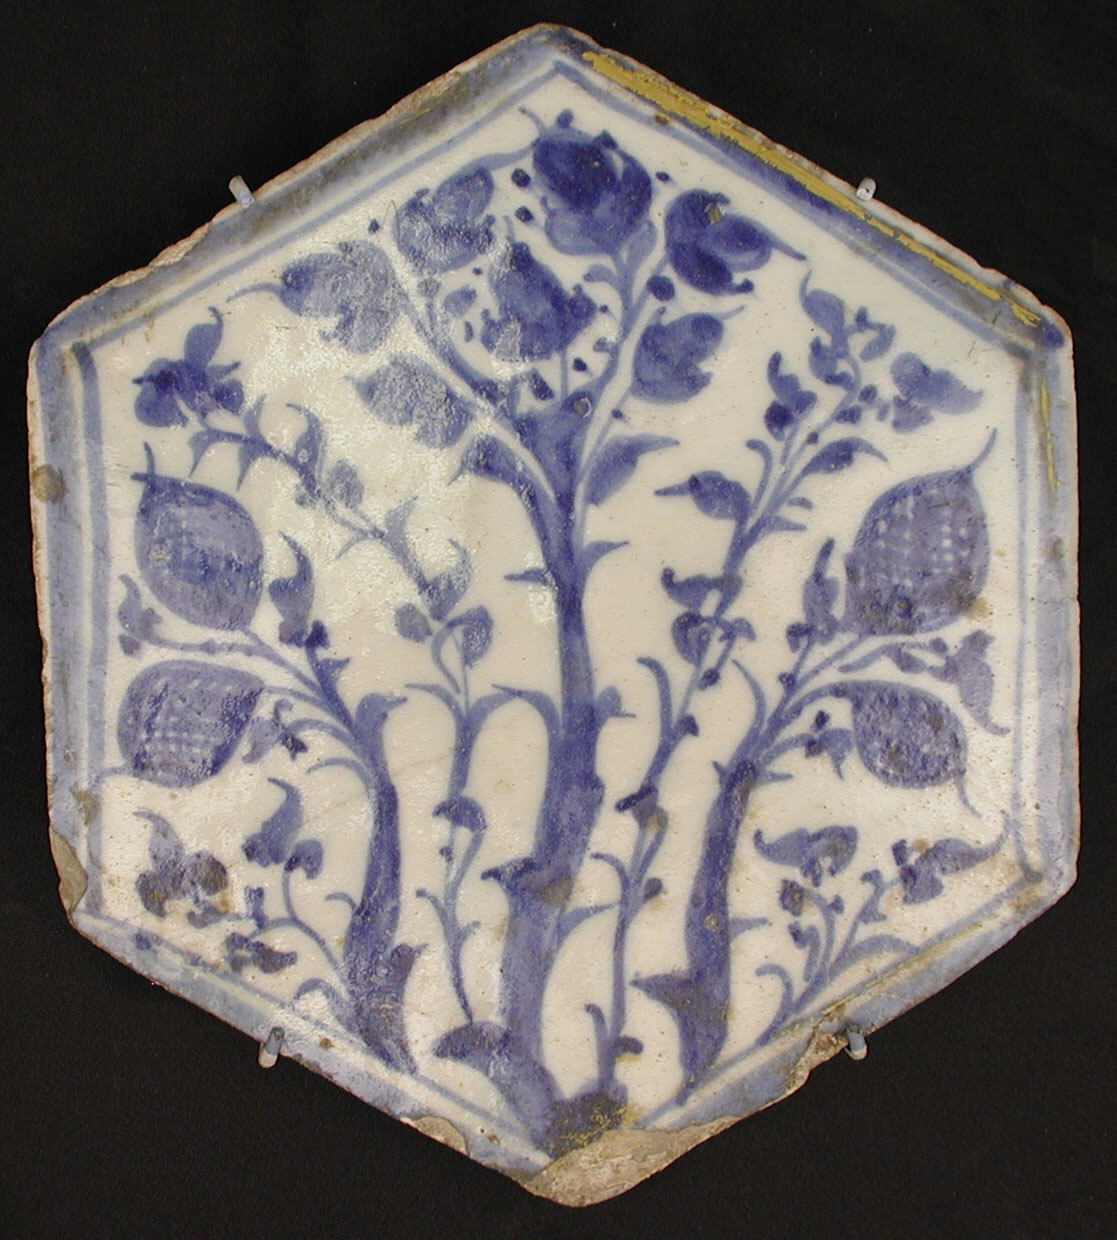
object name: hexagonal tile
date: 1451-1500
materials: stonepaste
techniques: painting, underglaze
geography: egypt